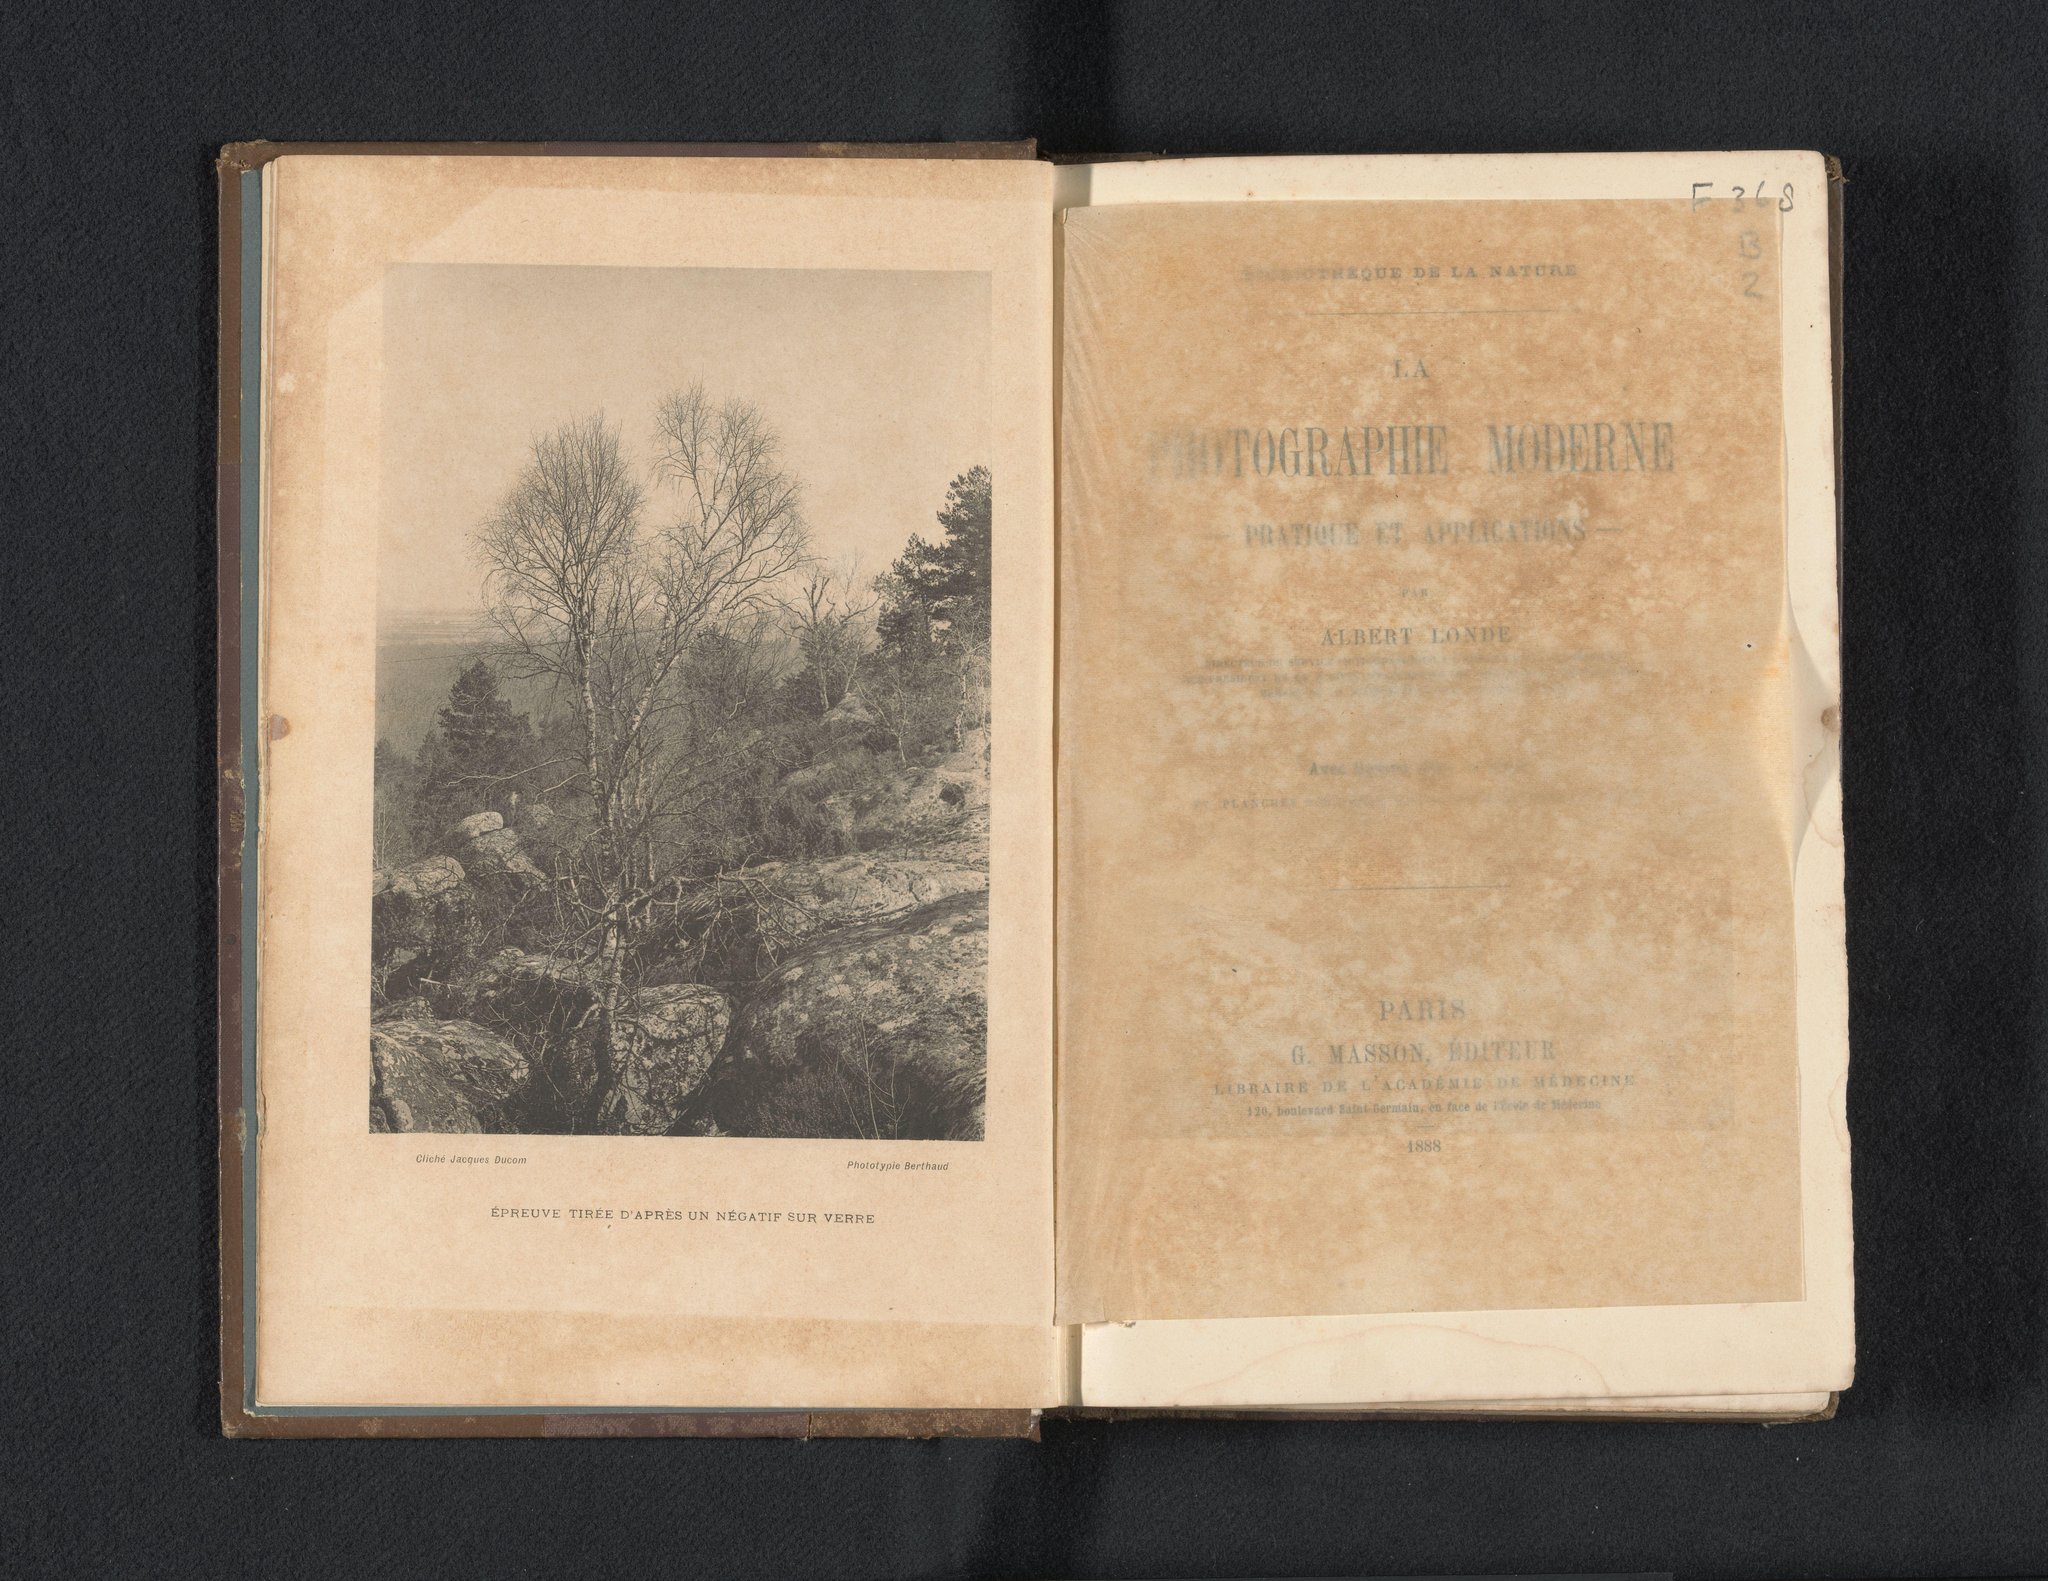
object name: page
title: Landschap met rotsen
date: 1883-1888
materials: paper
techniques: photograph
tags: landscapes in the temperate zone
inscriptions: inscription: ‘Épreuve tirée d'après un négatif sur verre’